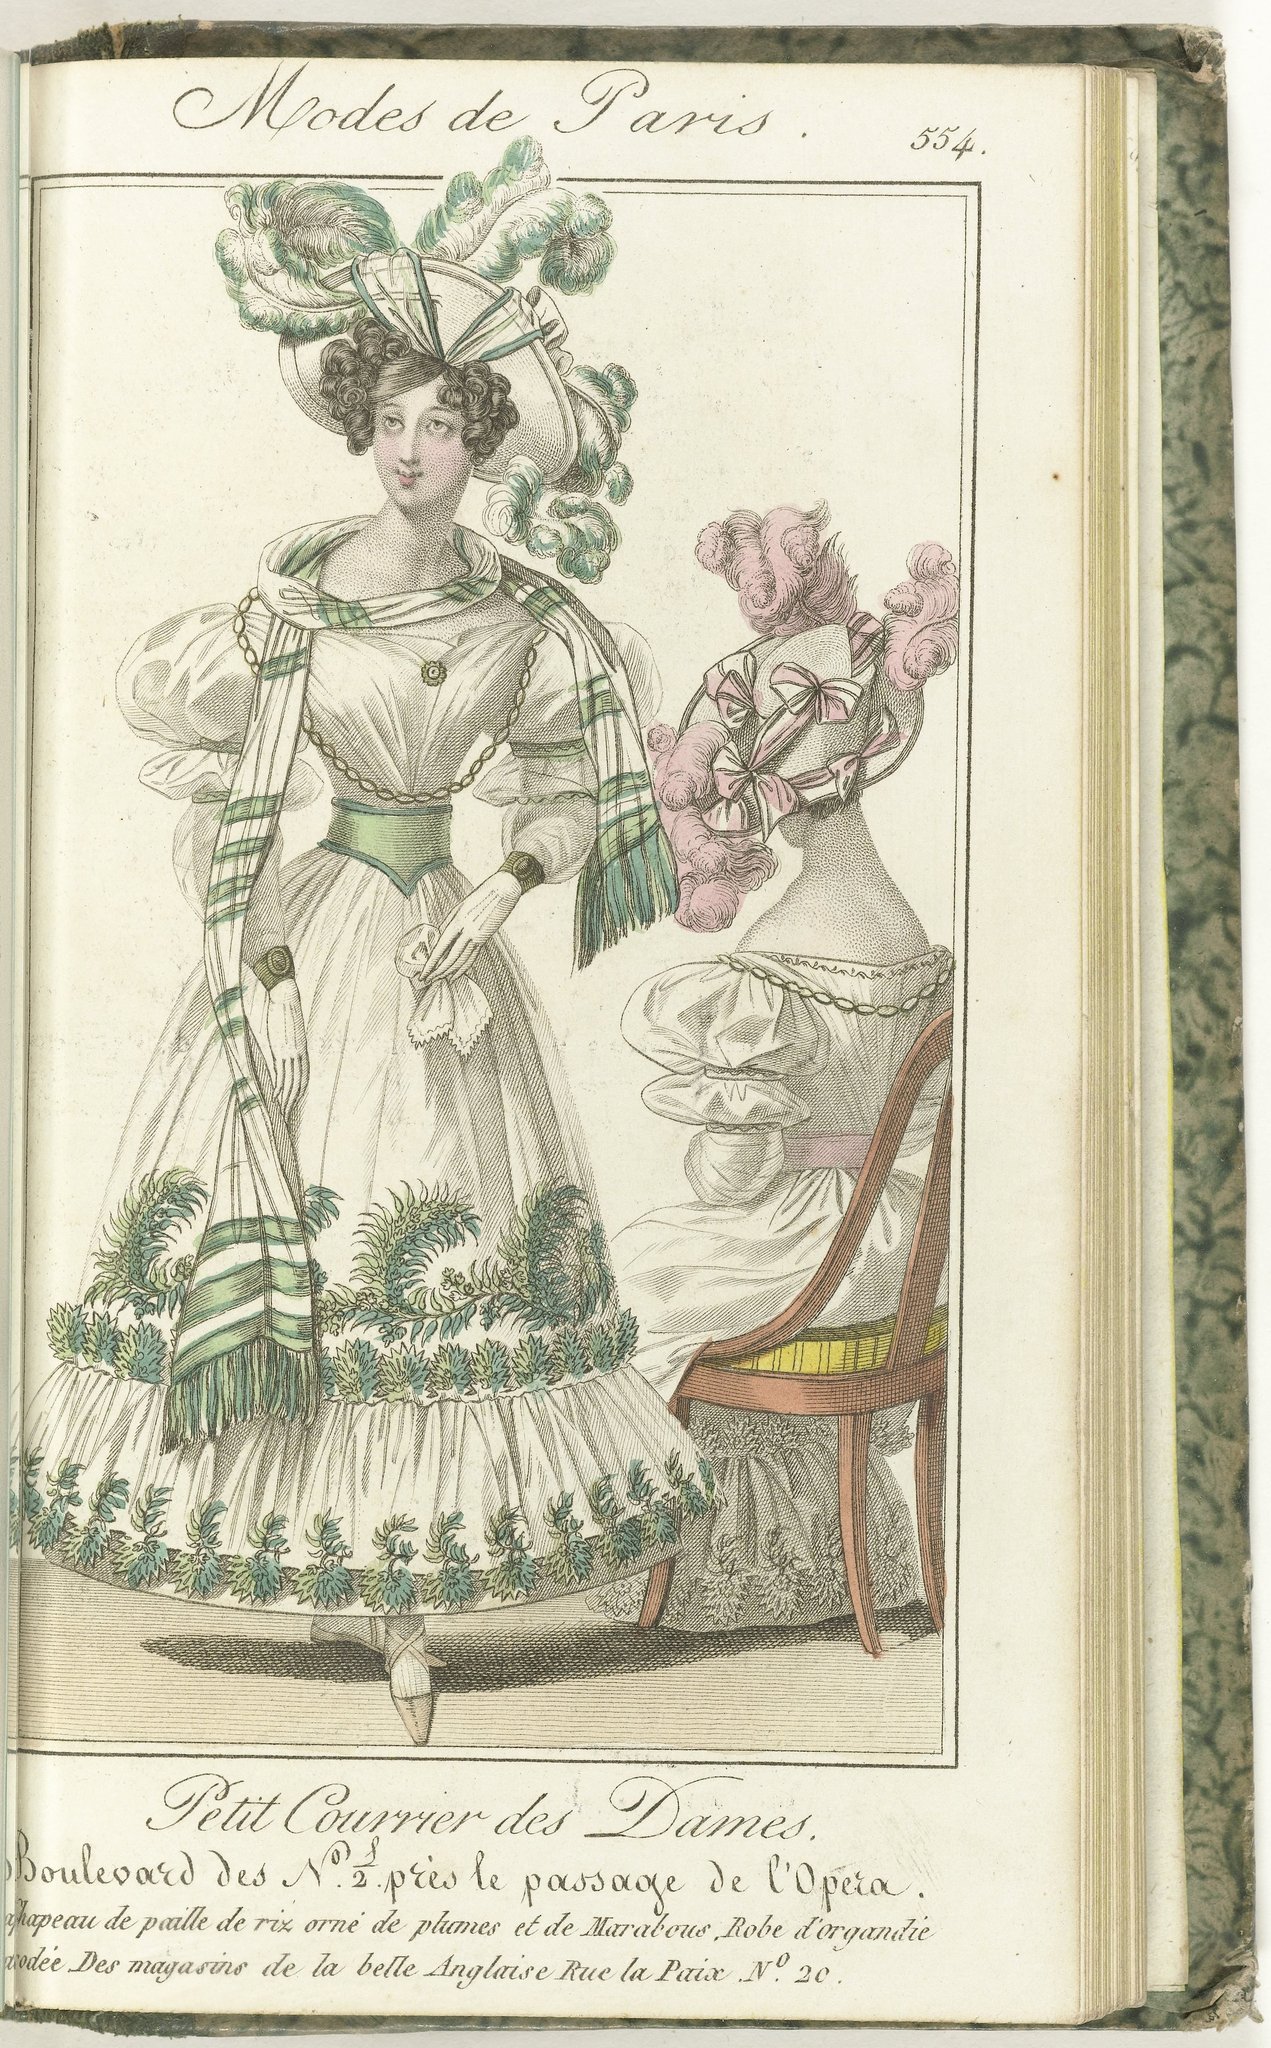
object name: fashion print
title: Petit Courrier des Dames, 15 mai 1828, No. 554 : Chapeau de paille de riz...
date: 1828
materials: paper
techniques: engraving, hand coloring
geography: paris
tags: handkerchief (+ women's clothes), clothing for the upper part of the body (shawl) (+ women's clothes), embroidery (ornamentation) (+ women's clothes), fashion plates, head-gear: hat (+ women's clothes), dress, gown (+ women's clothes), bracelet, wristlet (+ women's clothes), necklace (+ women's clothes)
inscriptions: title: ‘Petit Courrier des Dames.’, title: ‘Modes de Paris.’, caption: ‘Chapeau de paille de riz orné de plumes et de Marabous, Robe d'Organdie brodée Des magasins de la belle Anglaise Rue la Paix No. 20.’, address: ‘Boulevard des Italiens No.2 près le passage de l'Opèra.’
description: Staande vrouw gekleed in een japon van organdie geborduurd met bladmotief. Op het hoofd een hoed van 'paille de riz' versierd met veren en maraboeveren. Om de hals een lange geruite sjaal met aan de uiteinden franjes. Zakdoek in de hand. Zittende figuur in eenzelfde japon, op de rug gezien. Prent uit het modetijdschrift Petit Courrier des Dames (1821-1868). Ingebonden (met enkele pp. Le Journal des Dames et des Modes). 15 Januari 1827 t/m 20 maart 1830. Incompleet.